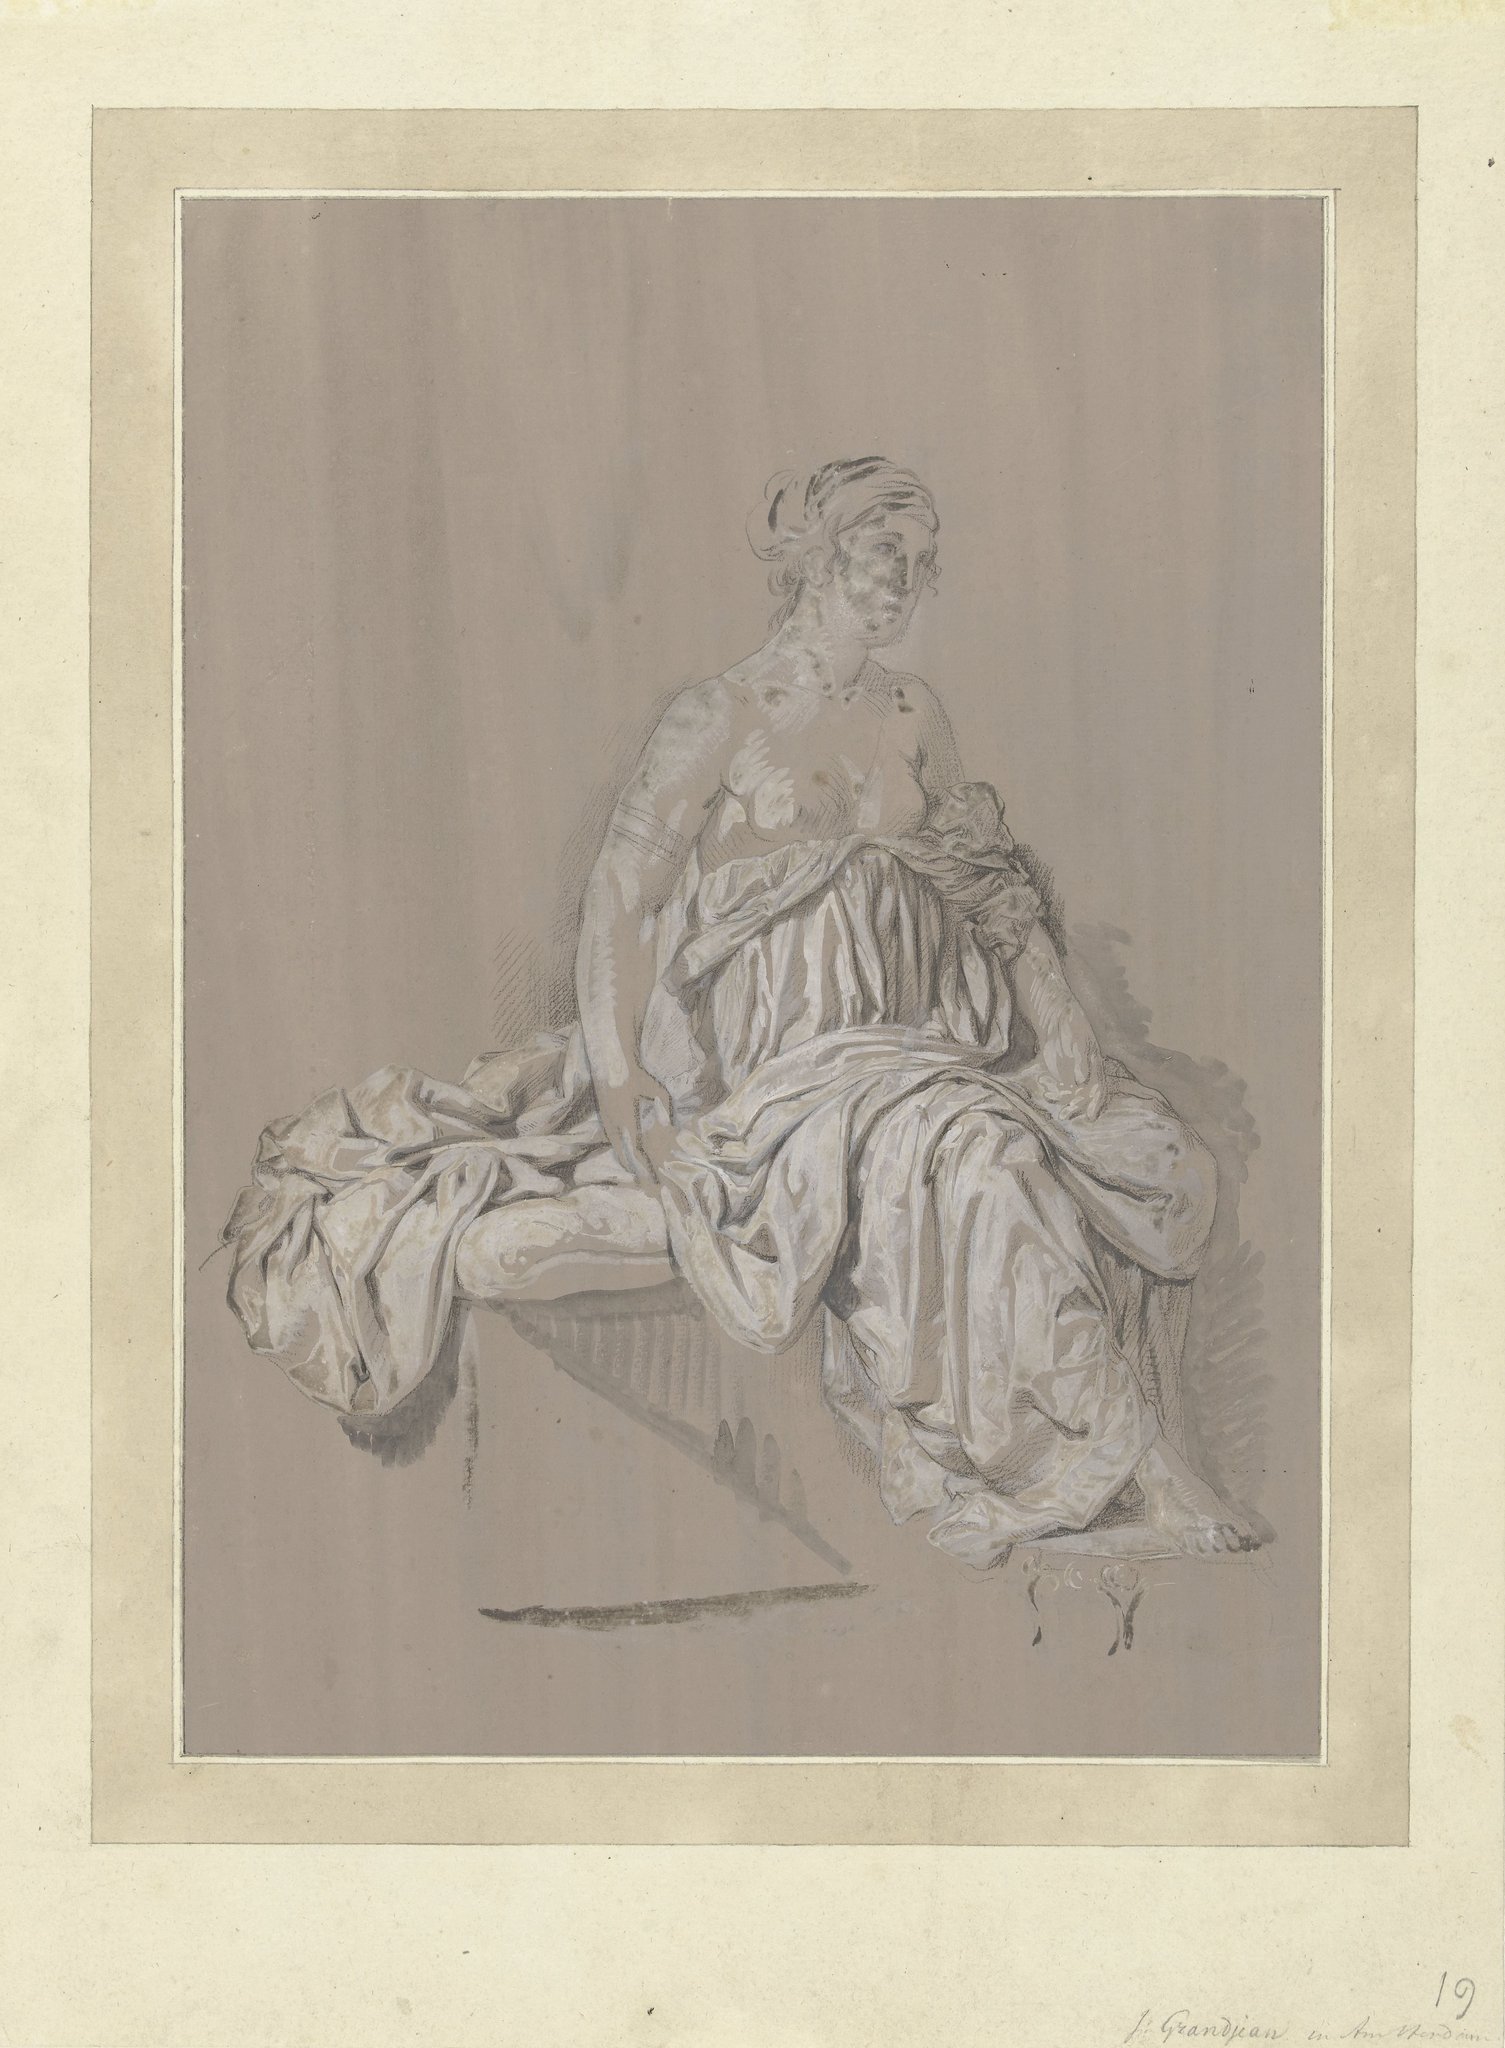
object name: drawing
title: Zittende vrouw met ontbloot bovenlichaam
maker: jean grandjean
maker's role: draughtsman, print maker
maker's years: 1752-1781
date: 1765-1781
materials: chalk, paint, paper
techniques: brush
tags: drapery, draped garment, 'gewandgebung'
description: Zittende vrouw met ontbloot bovenlichaam, de rechtervoet op een bankje. Draperiestudie.